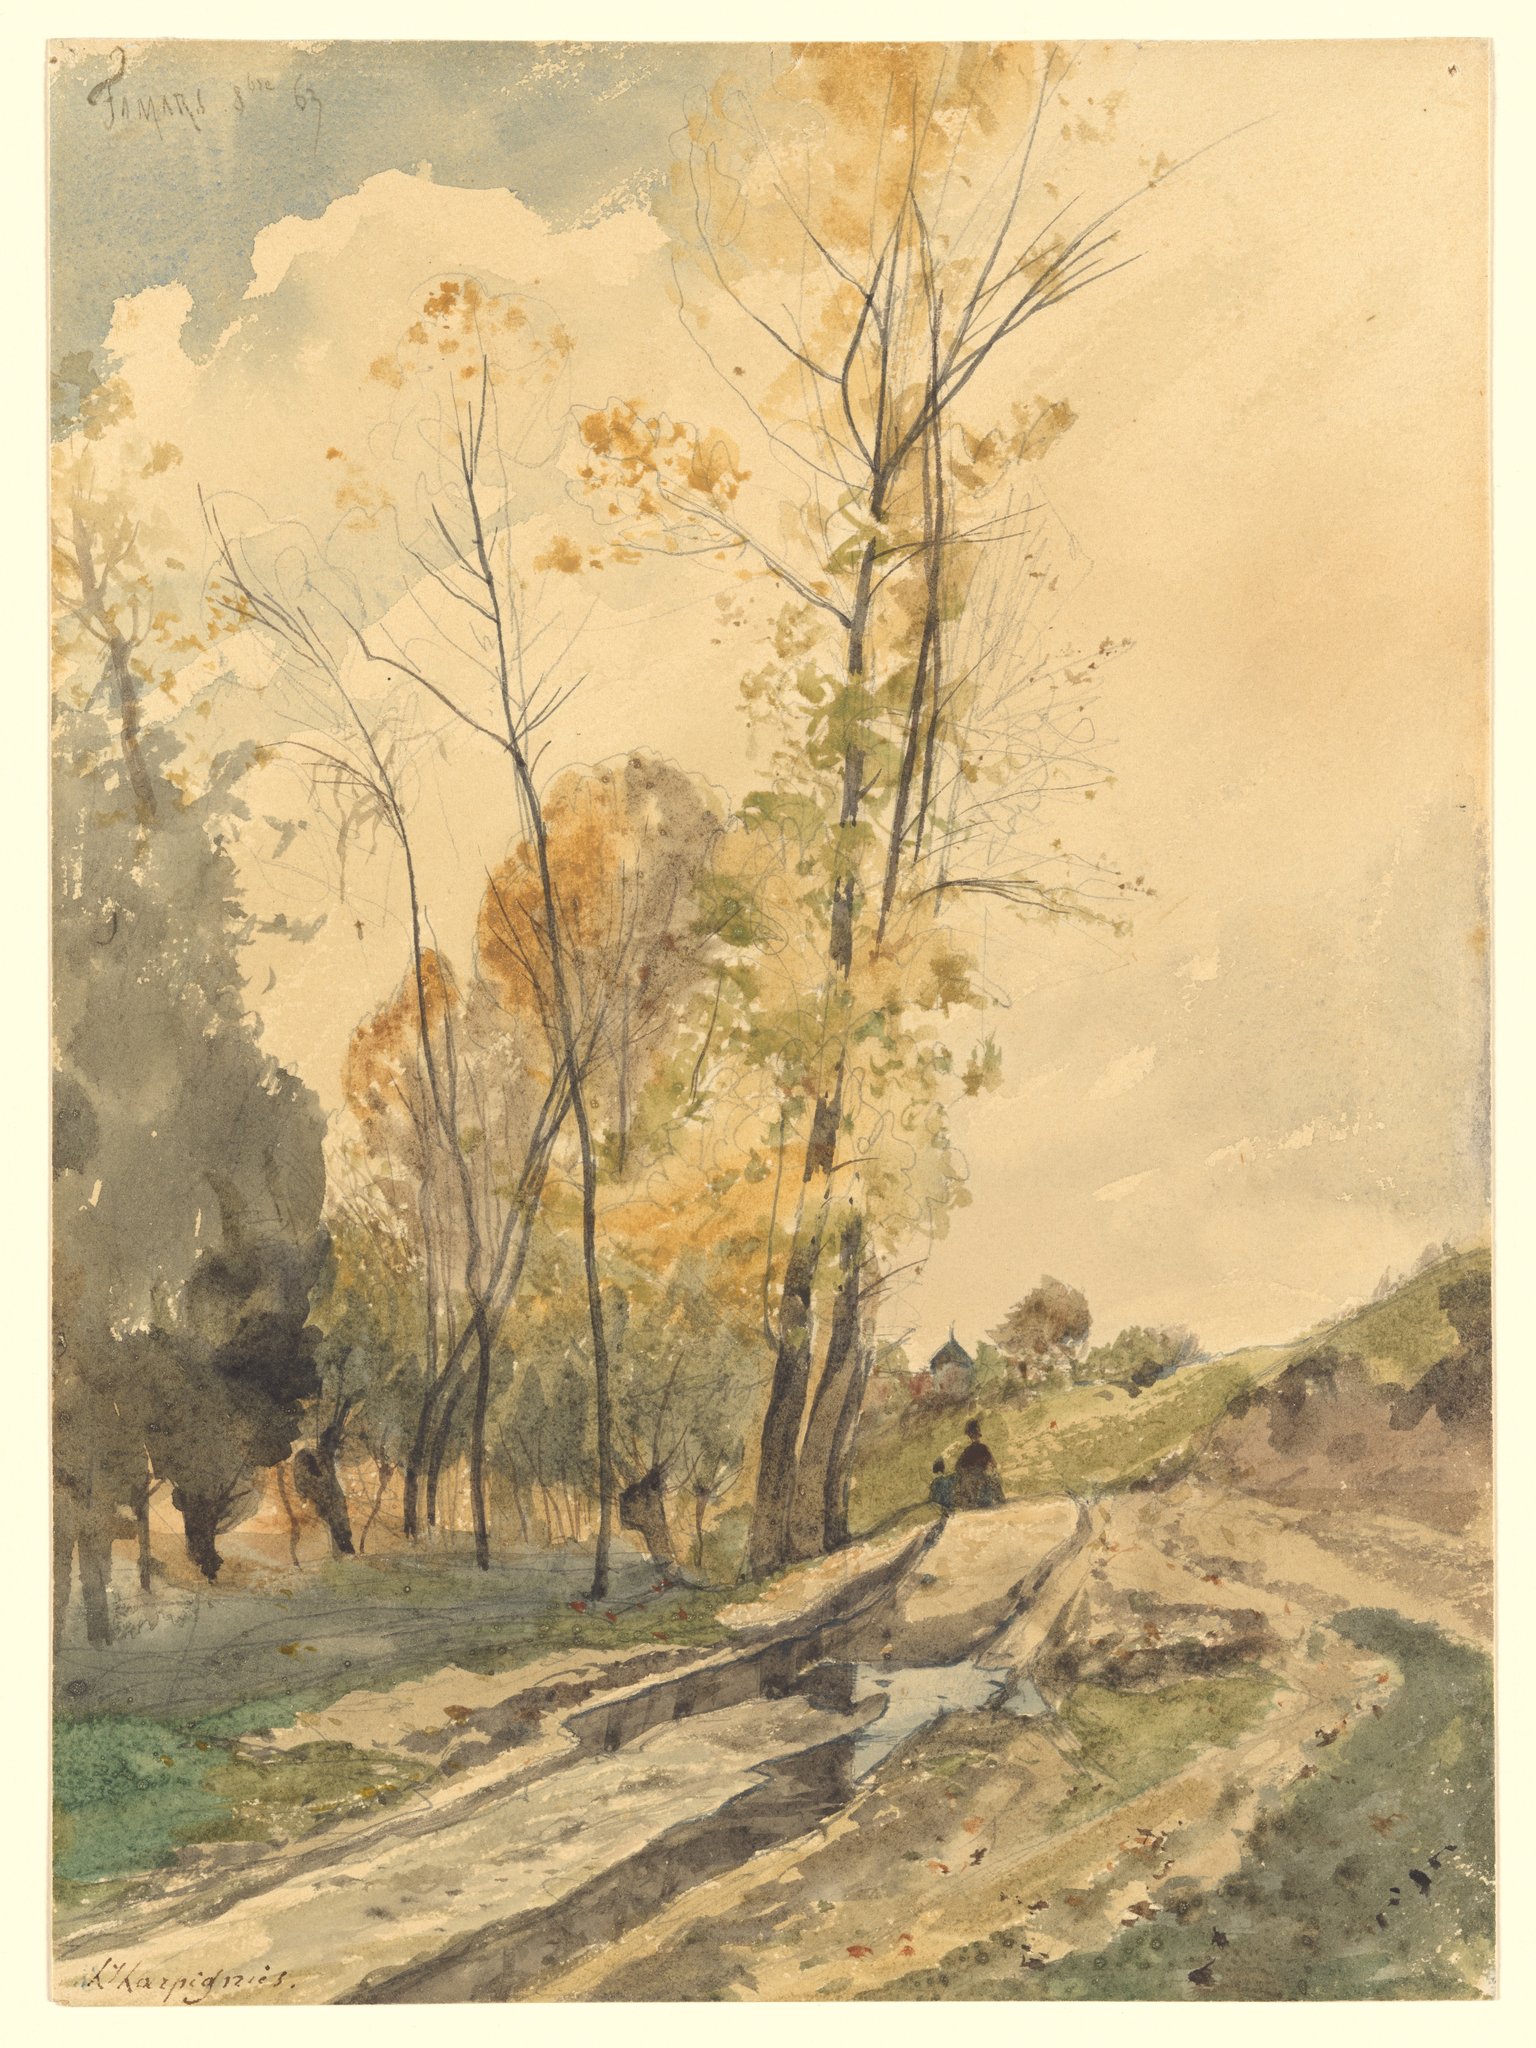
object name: drawing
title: Landscape at Famars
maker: henri-joseph harpignies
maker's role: artist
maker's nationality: french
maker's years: 1819-1916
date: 1863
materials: graphite, watercolor, paper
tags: landscapes